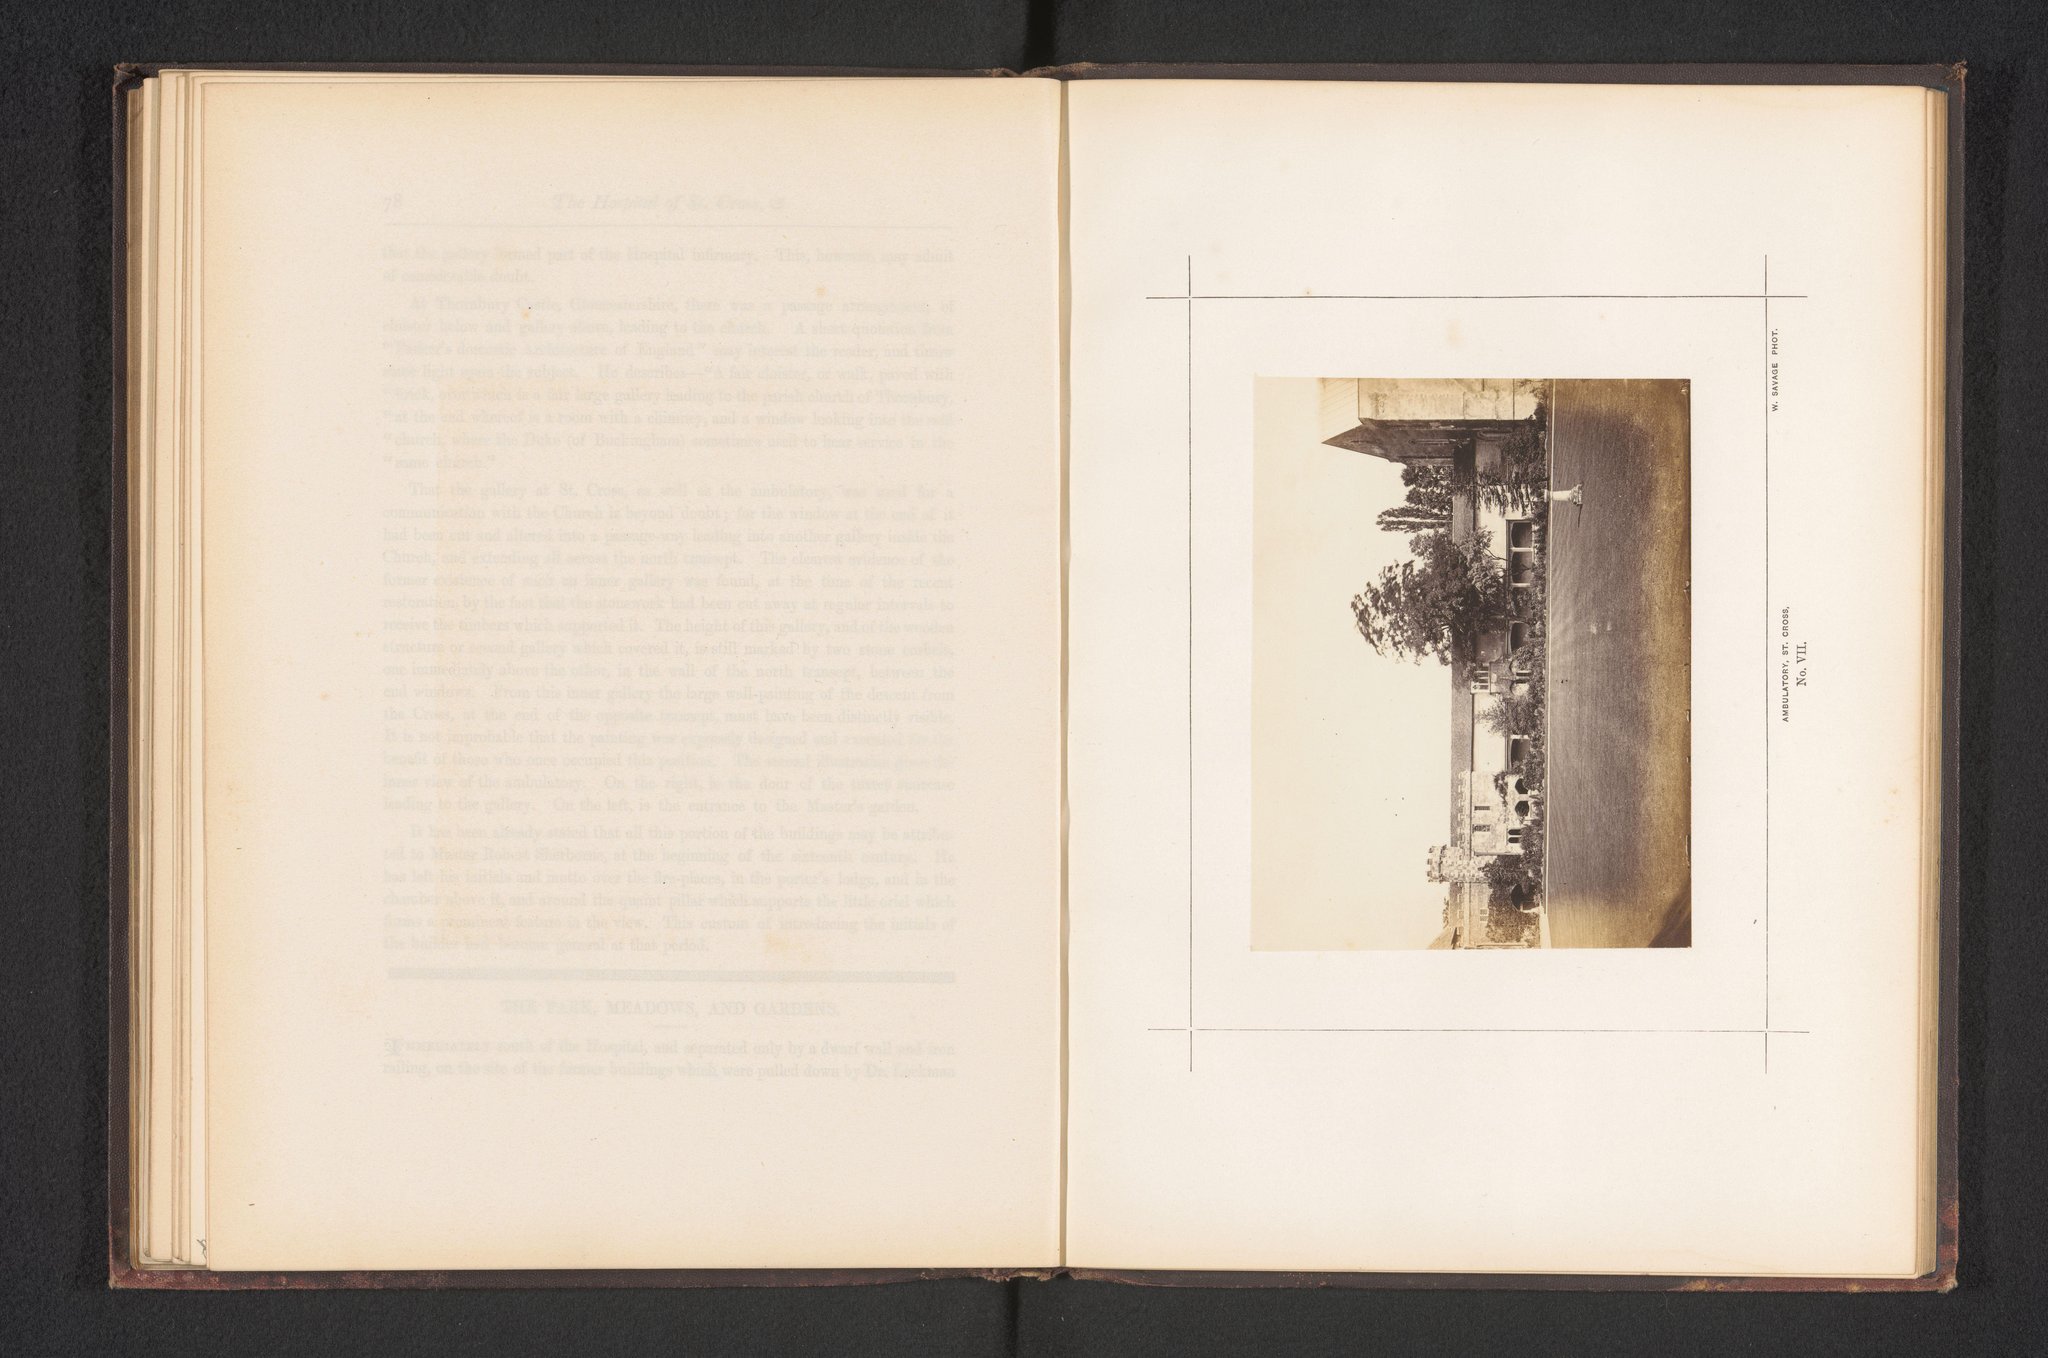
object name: page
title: Ambulatory, St. Cross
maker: william savage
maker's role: fotograaf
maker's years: 1817-1887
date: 1863-1868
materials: photographic support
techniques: albumen print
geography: winchester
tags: parts of church interior: ambulatory, church (exterior)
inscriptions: inscription: ‘No. VII.’